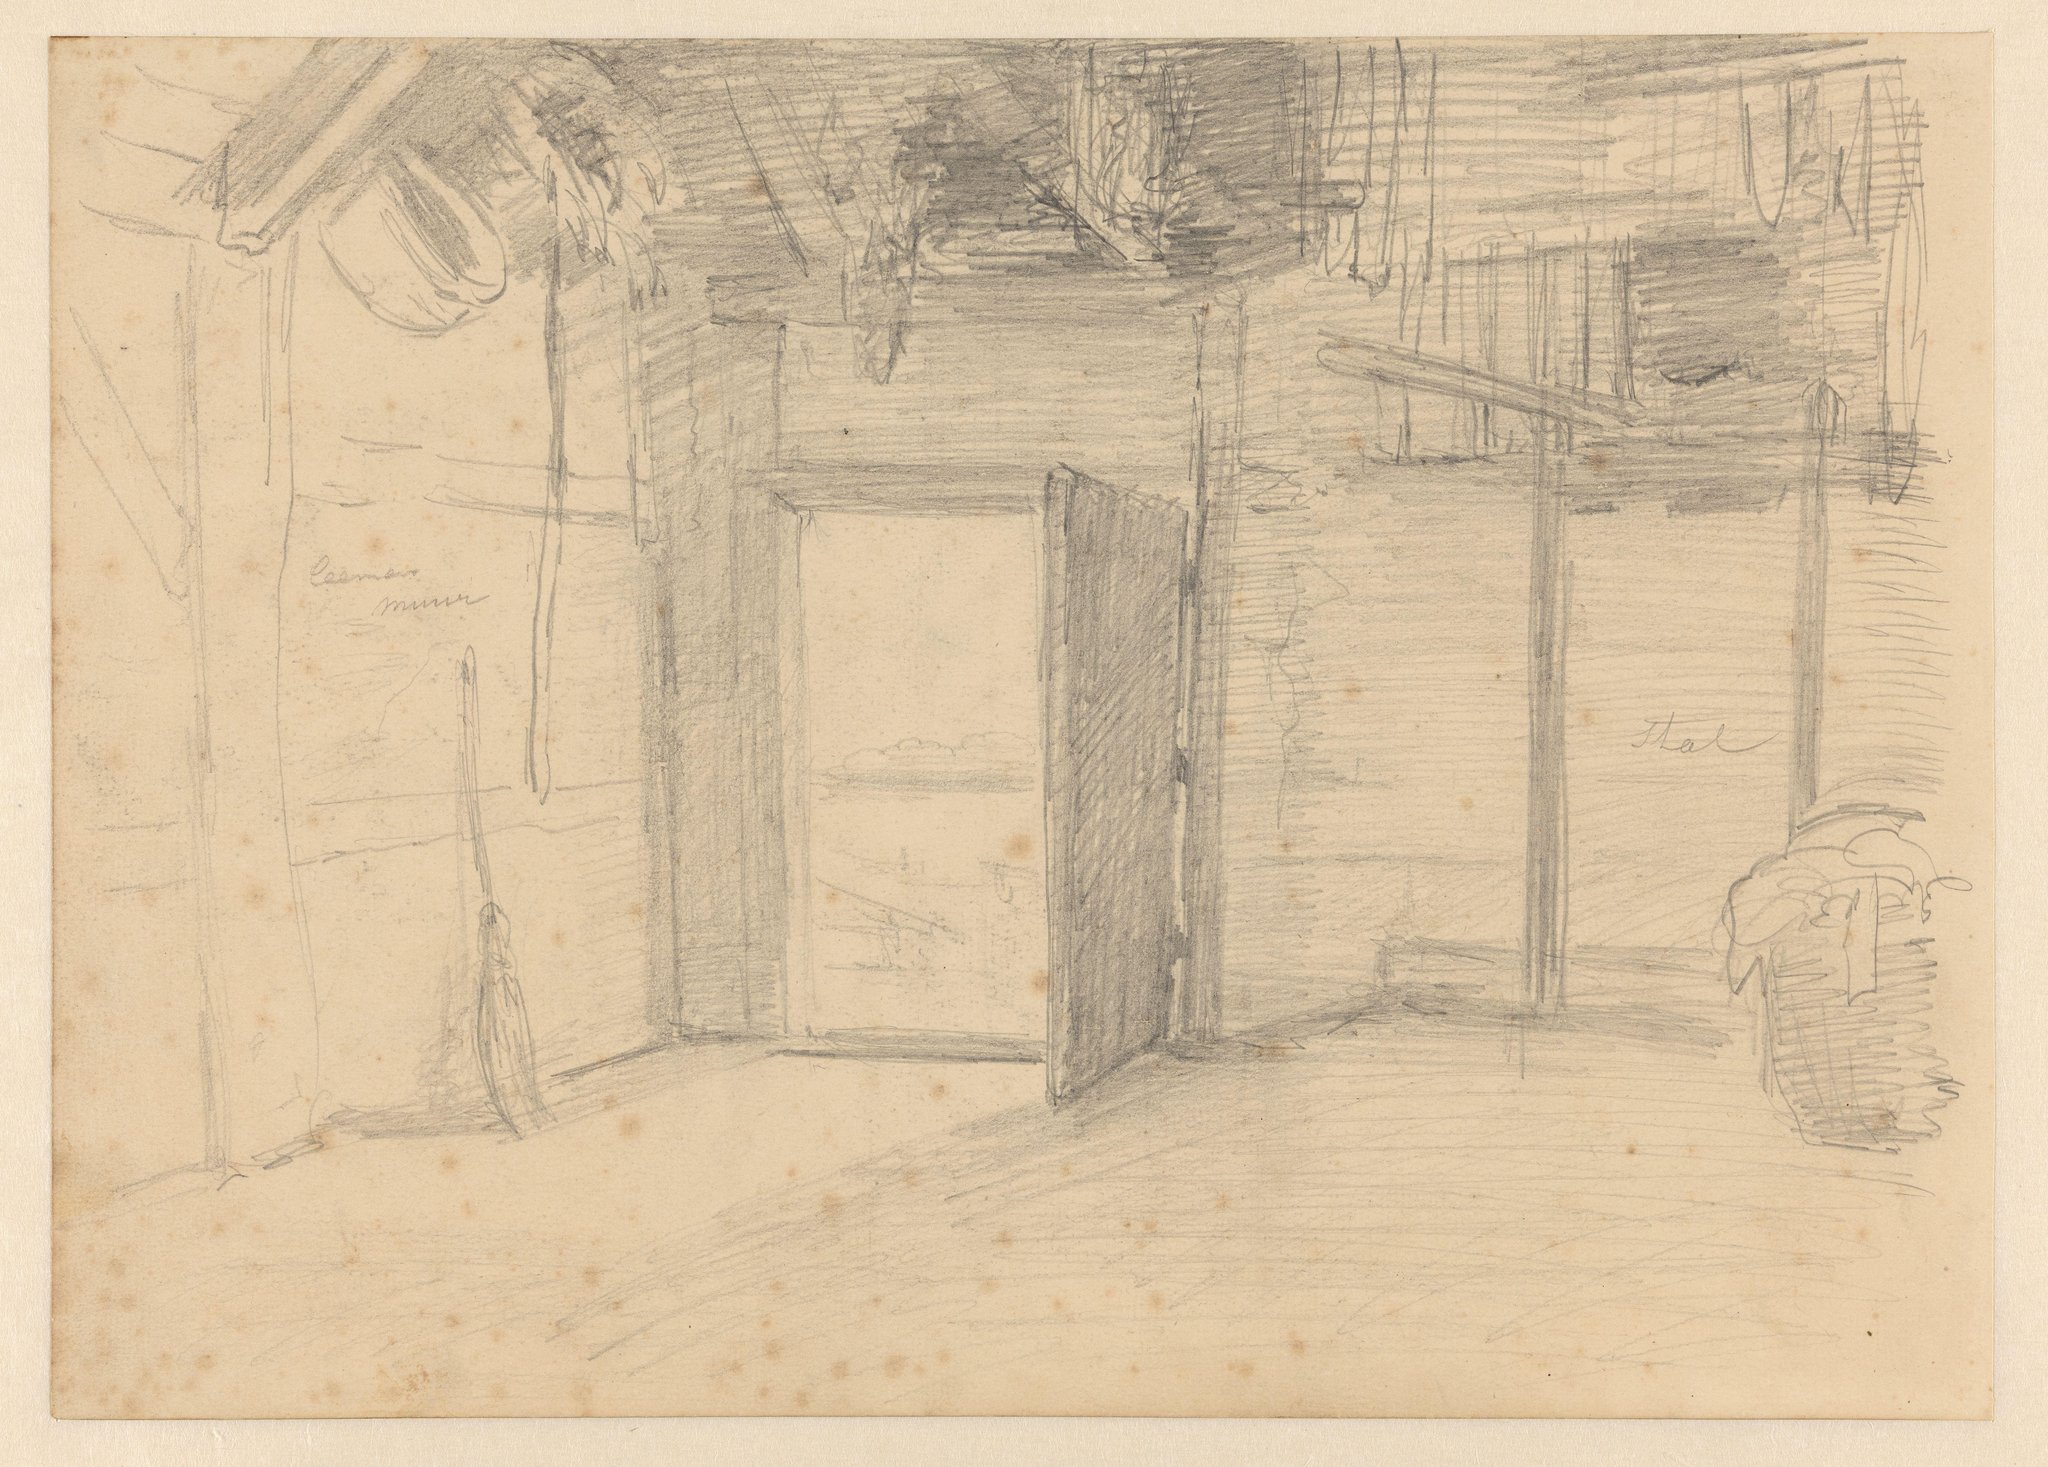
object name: drawing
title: Interieur van een boerenhuis; stal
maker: hendrik valkenburg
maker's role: draughtsman, painter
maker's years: 1826-1896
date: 1836-1896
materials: paper, pencil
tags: family life, interior of the house, stall, stable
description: Interieur van een boerenhuis; stal. Verso: Moeder met kinderen.